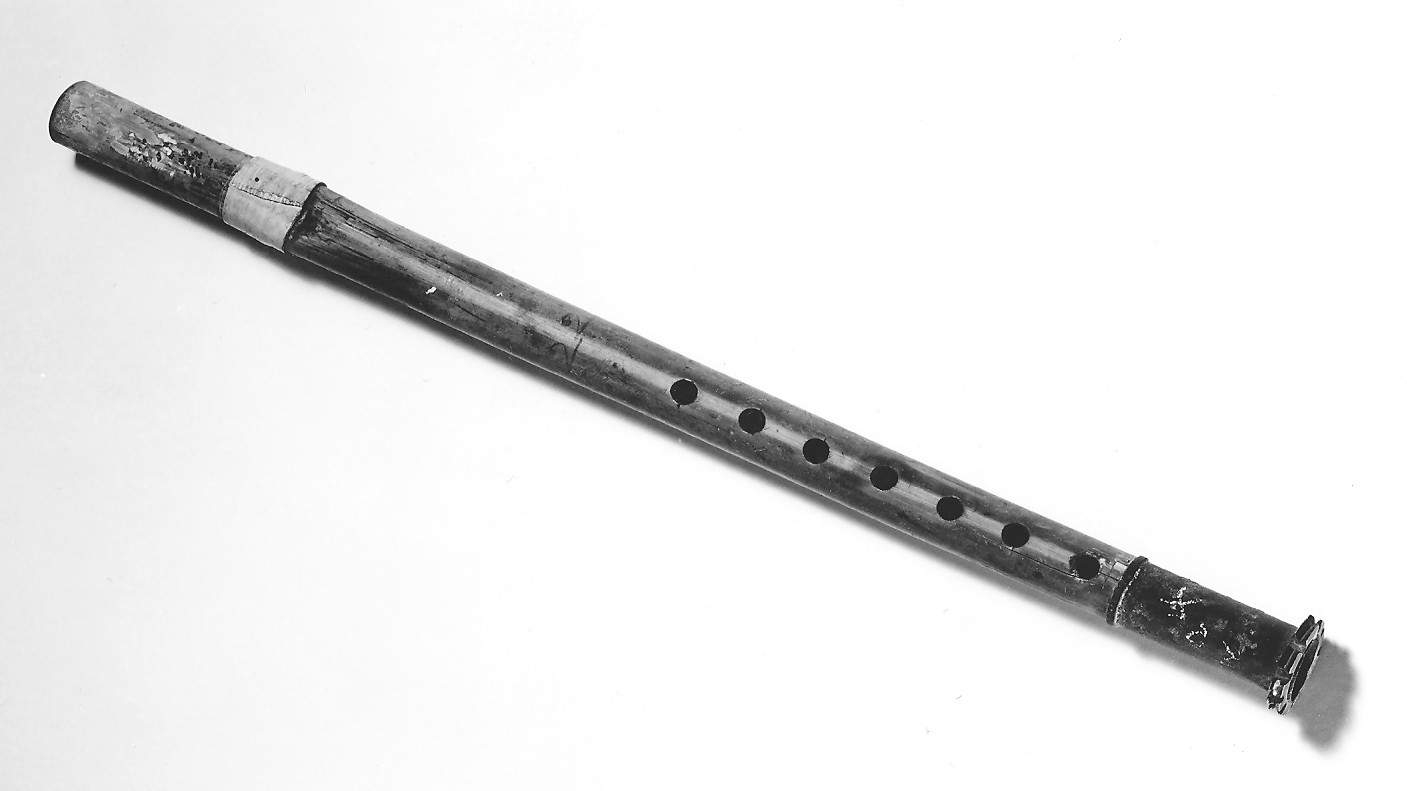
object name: flute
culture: indian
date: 1867-1900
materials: wood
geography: india